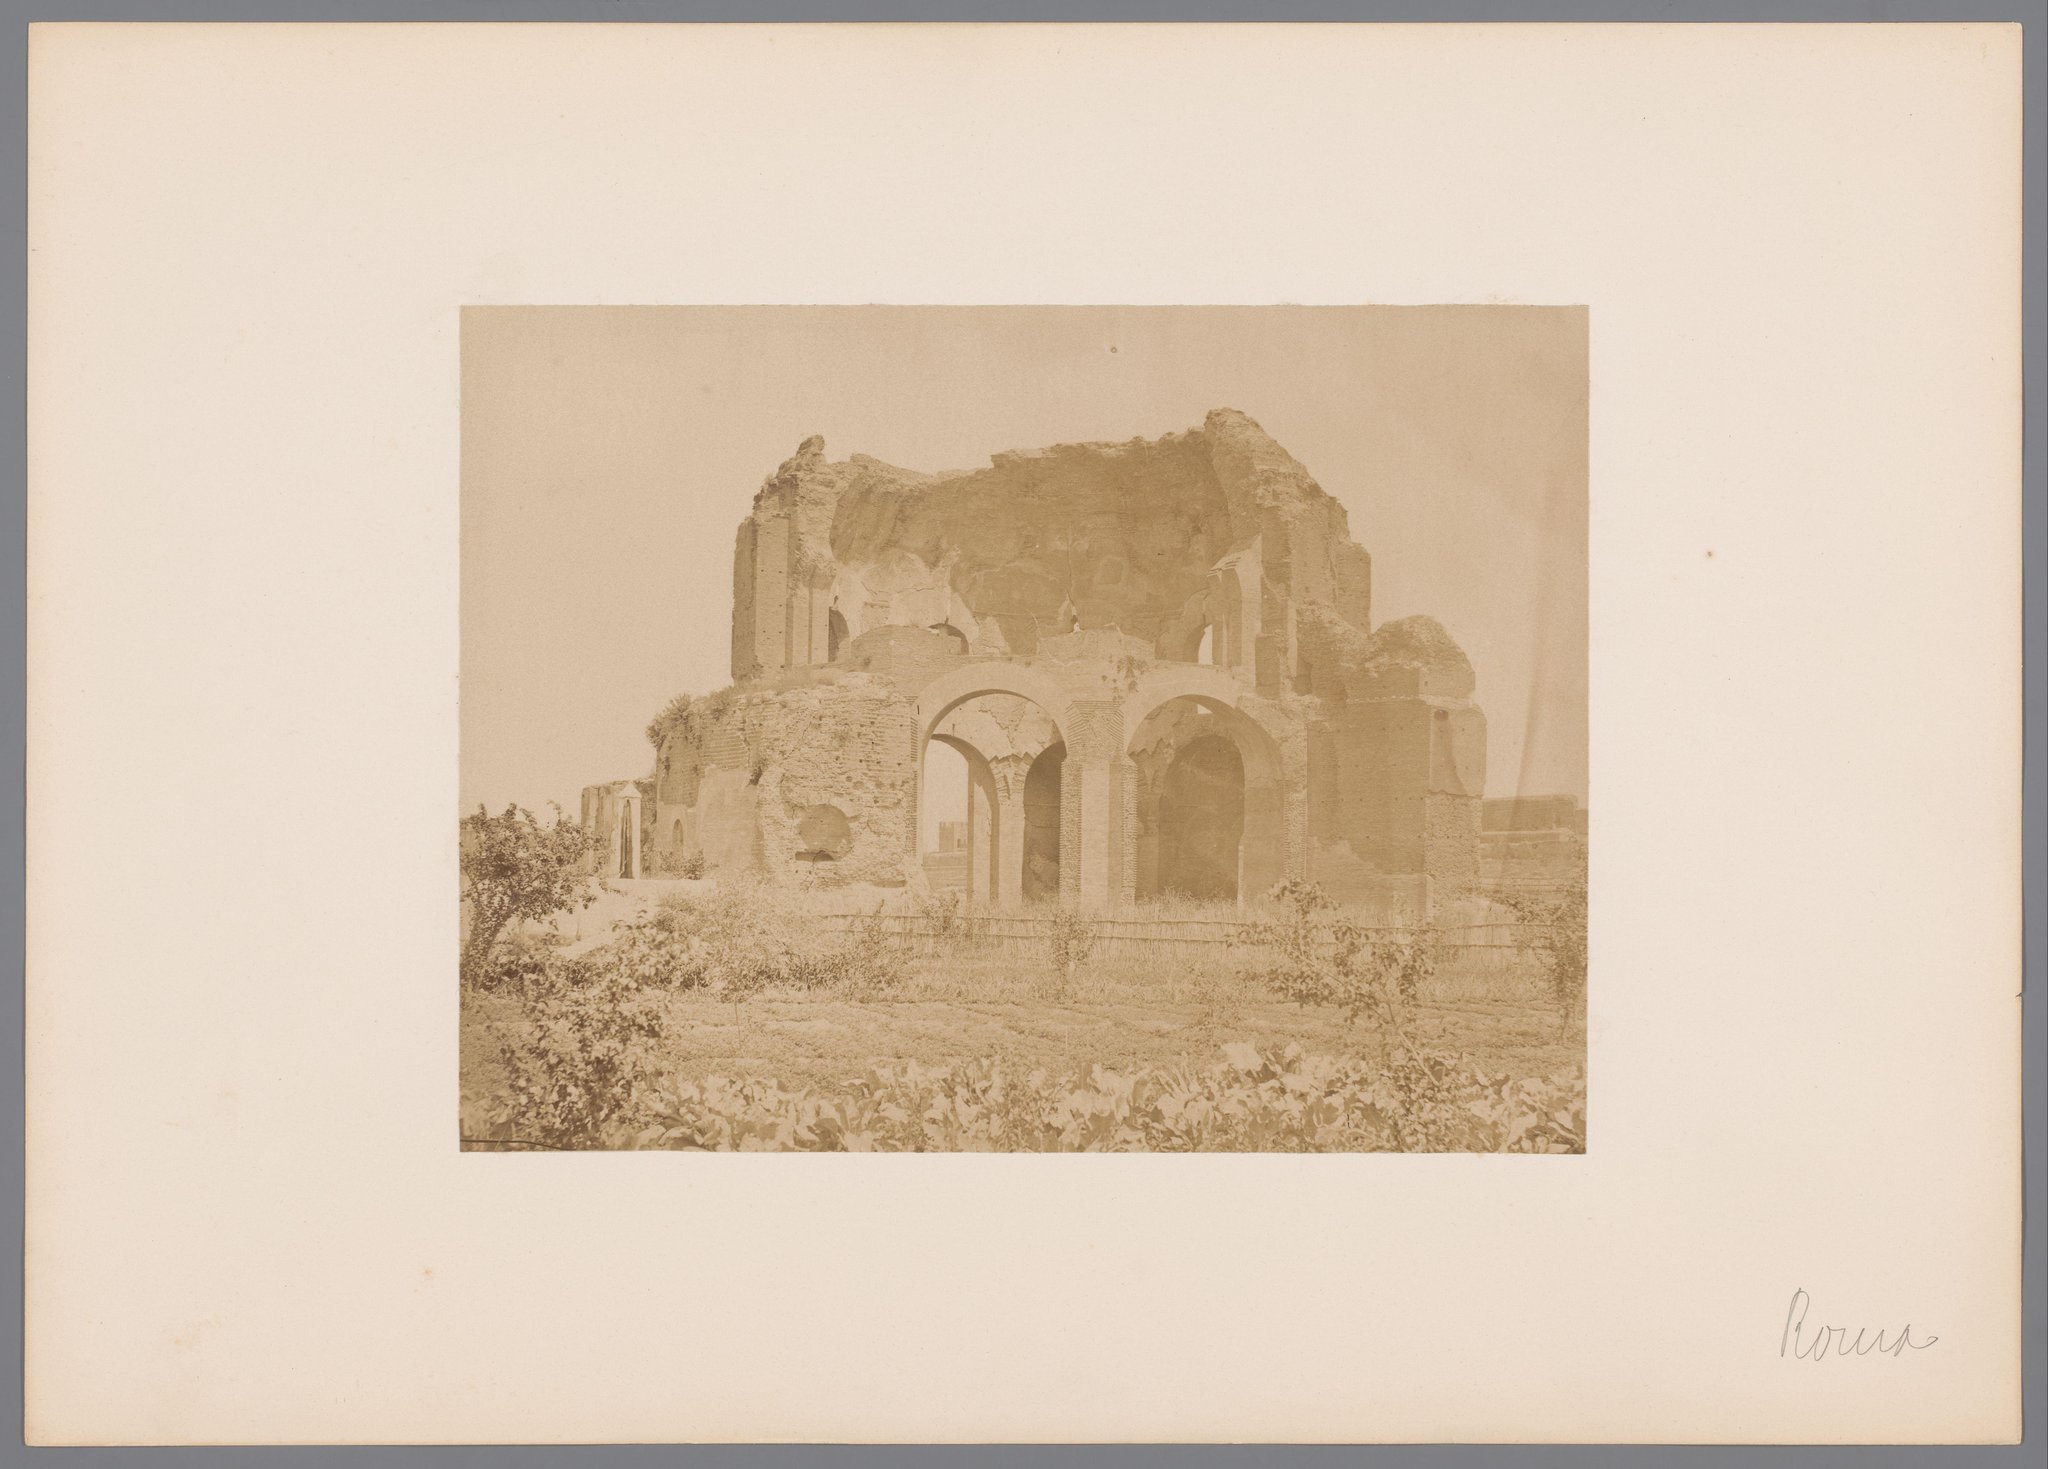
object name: photograph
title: Gezicht op de tempel van Minerva Medica te Rome, Italië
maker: Anonymous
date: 1851-1900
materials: cardboard, paper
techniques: albumen print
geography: rome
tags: ruin of a building ~ architecture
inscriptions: number: ‘42’, inscription: ‘Roma’, number: ‘89’